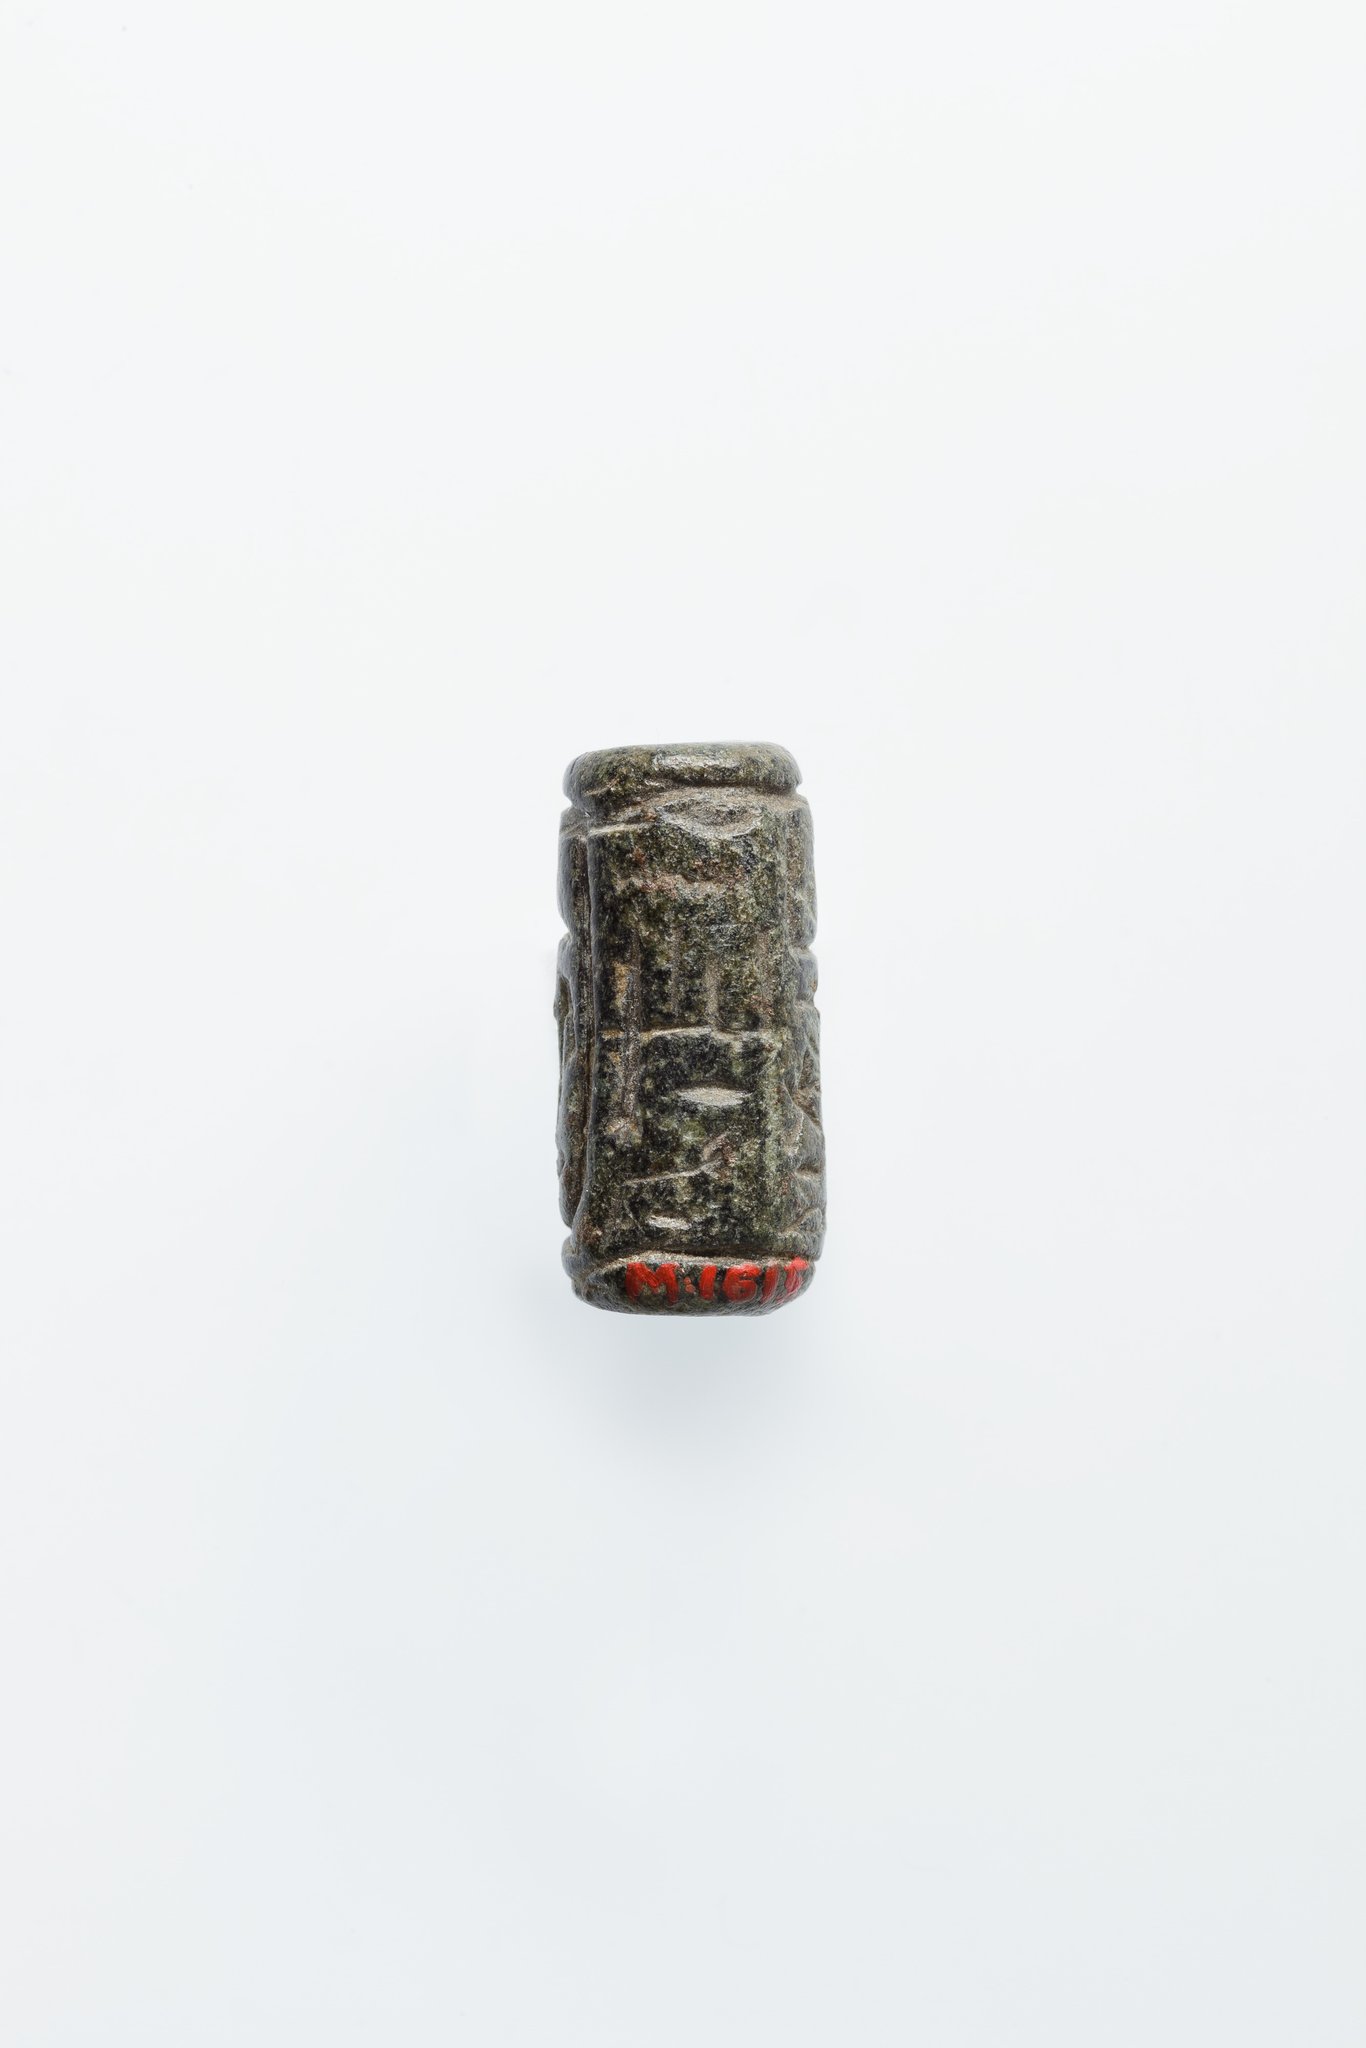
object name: cylinder seal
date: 2649-2100 BCE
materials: stone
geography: egypt